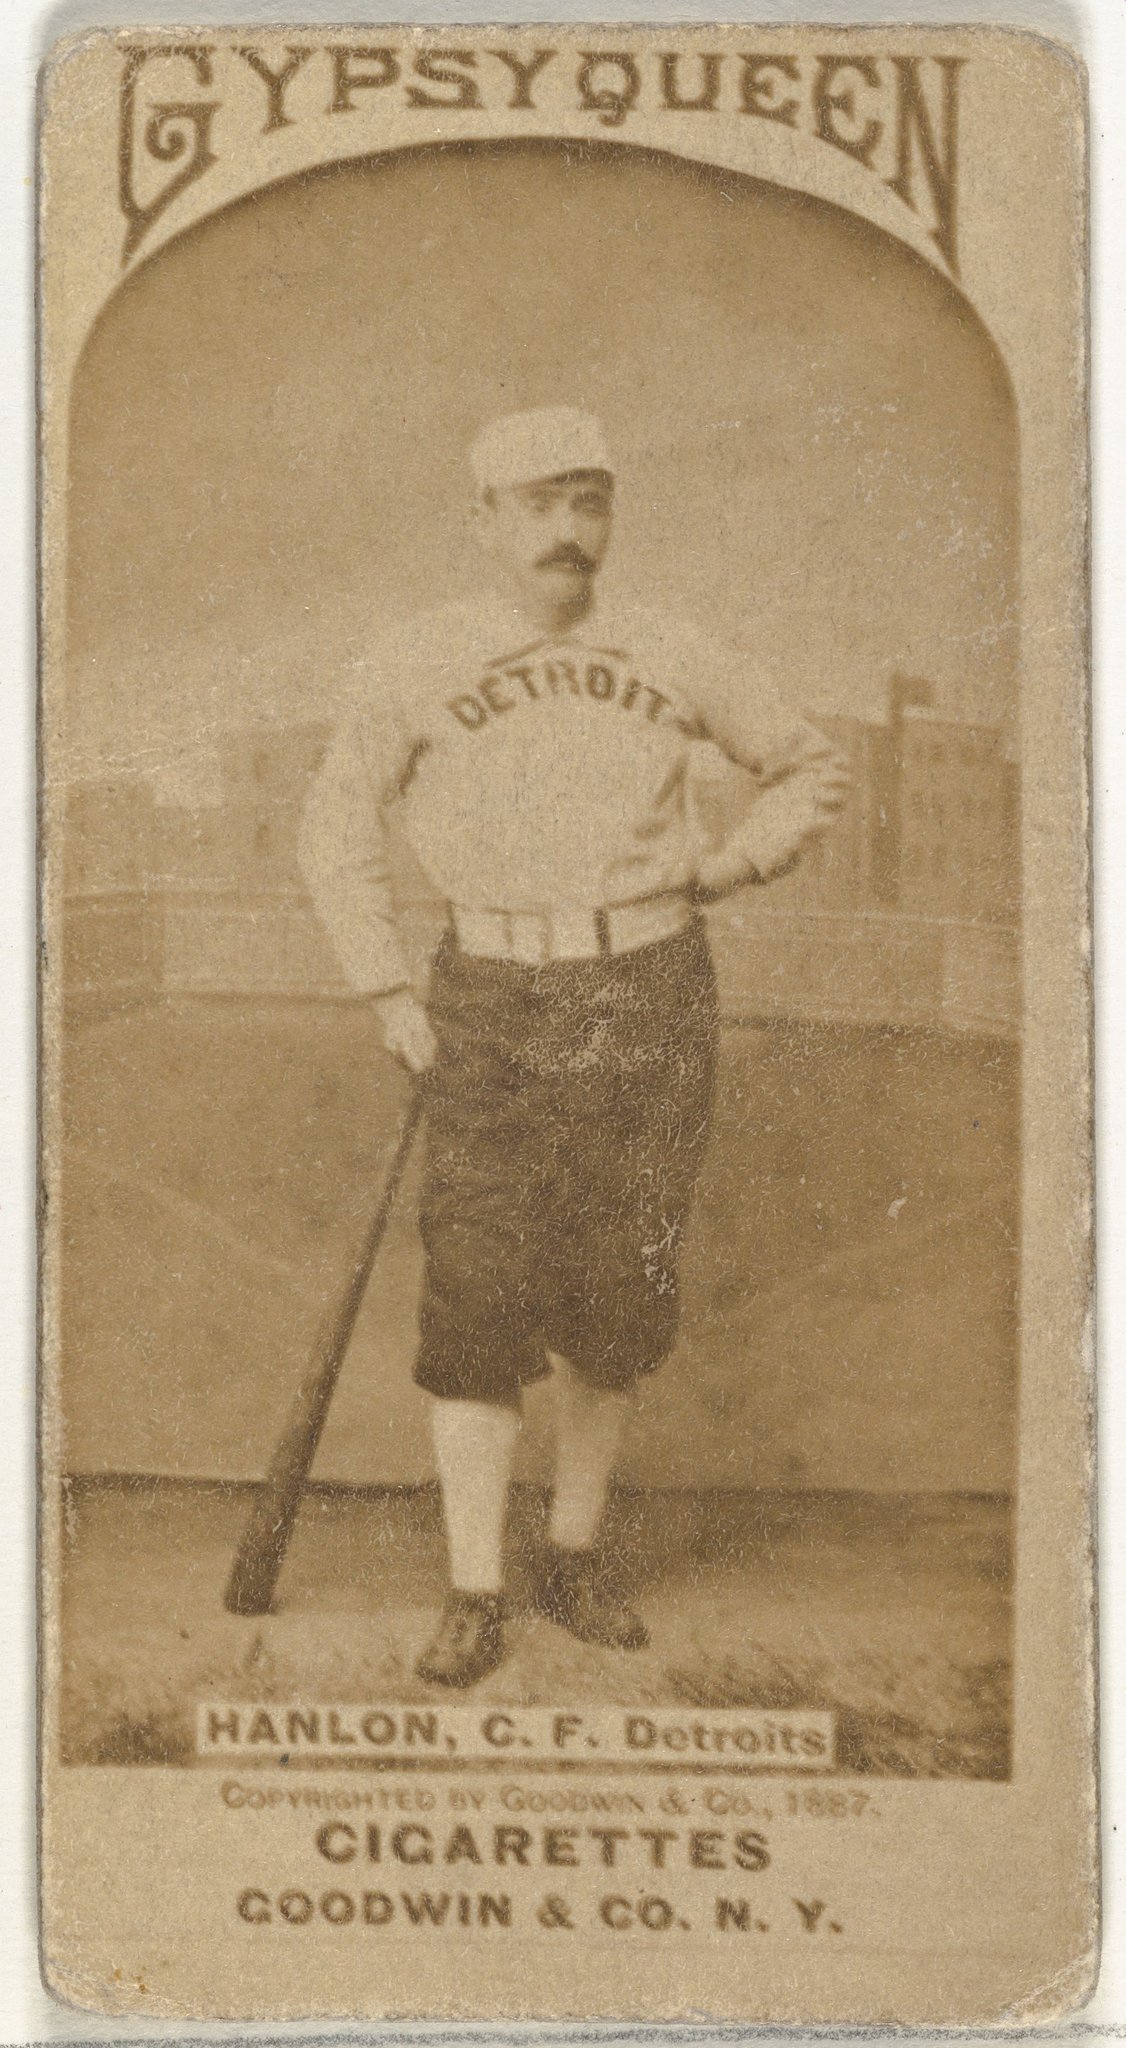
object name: baseball card, photograph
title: Edward Hugh "Ned" Hanlon, Center Field, Detroit Wolverines, from the Old Judge series (N172) for Old Judge Cigarettes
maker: goodwin & company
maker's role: publisher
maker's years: 1850-1950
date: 1887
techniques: albumen silver print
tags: men,portraits,baseball,athletes